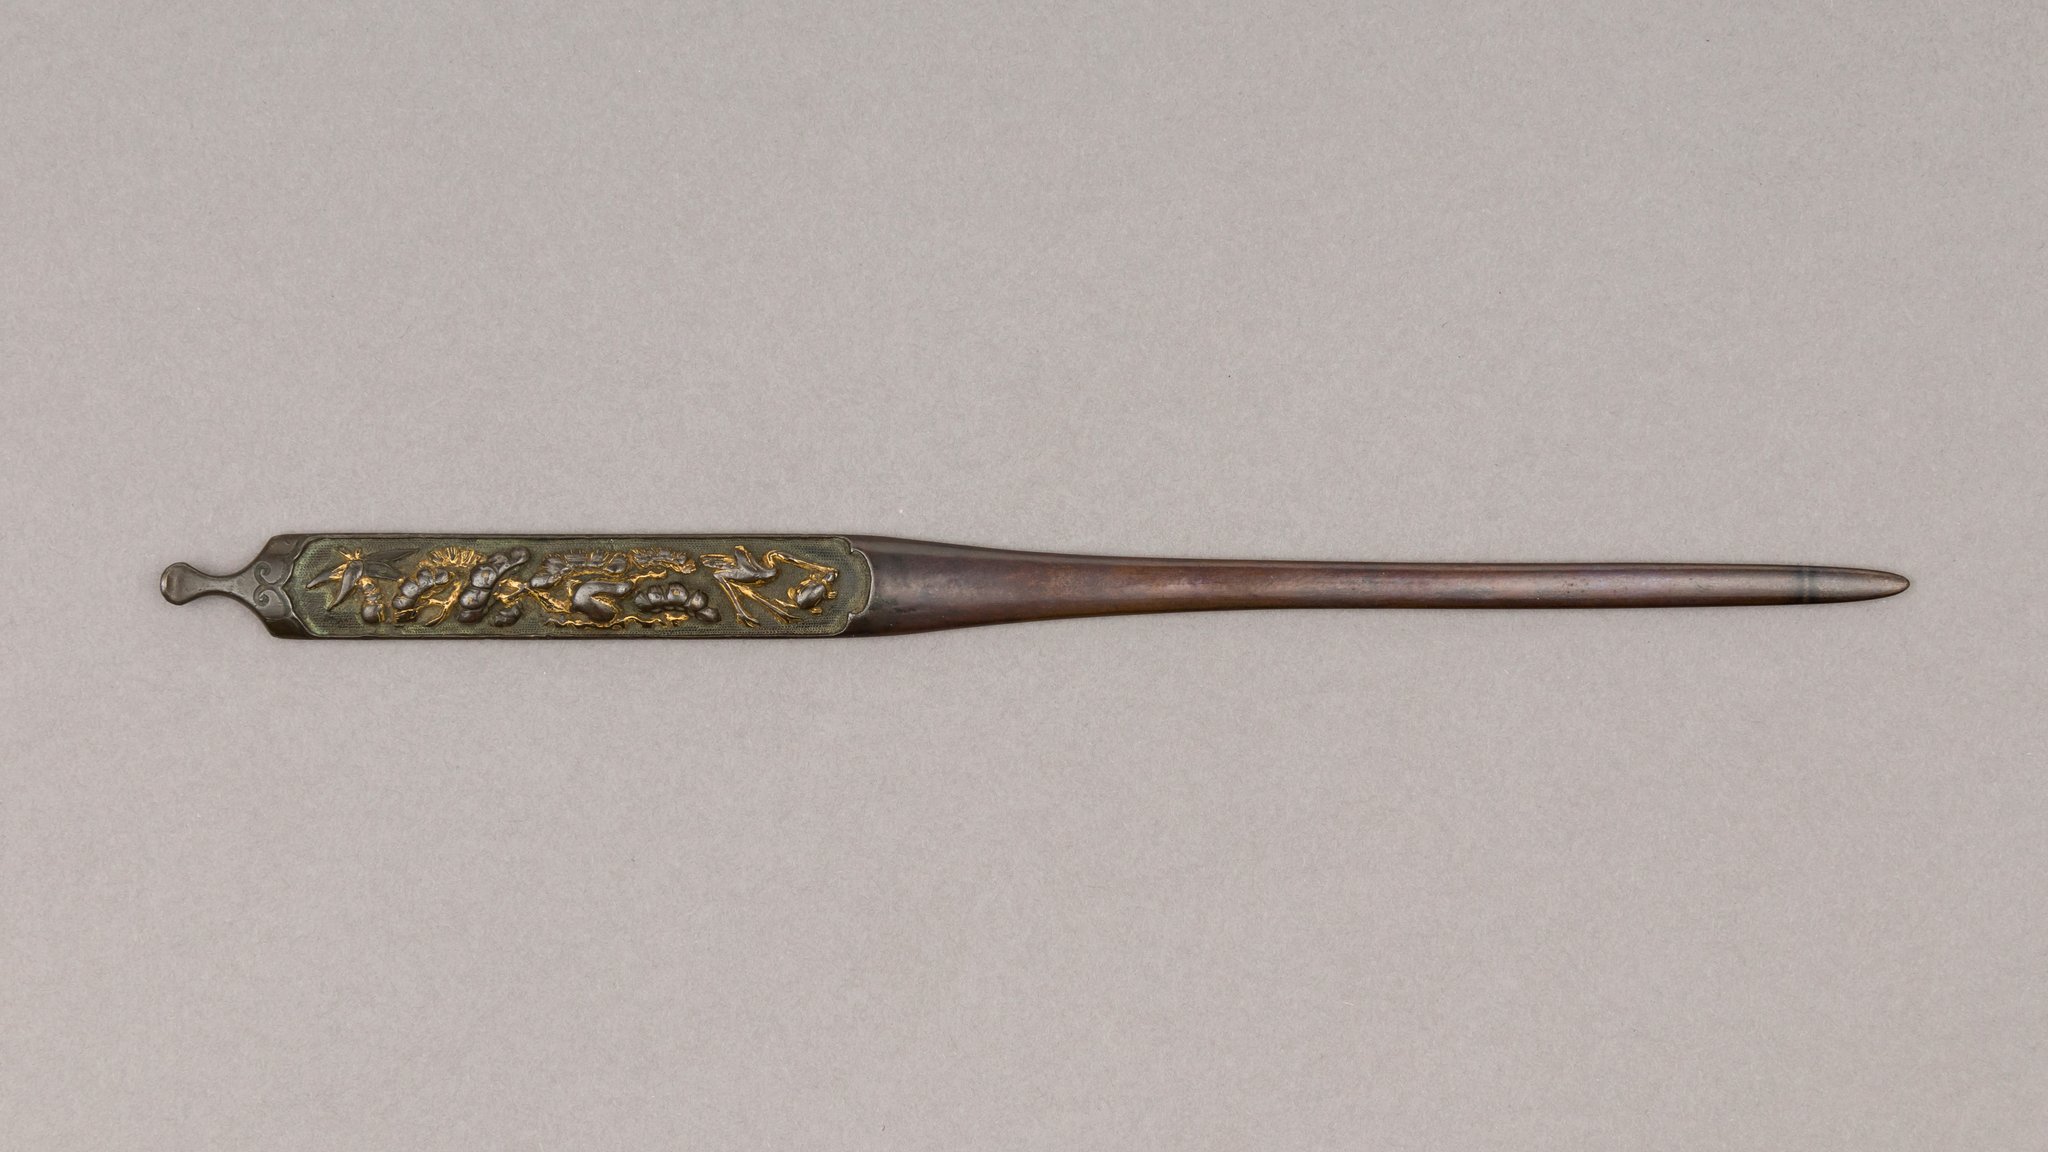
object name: hair dressing tool kogai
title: Hair Dressing Tool (Kogai)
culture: japanese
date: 1401-1433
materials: copper alloy, gold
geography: japan